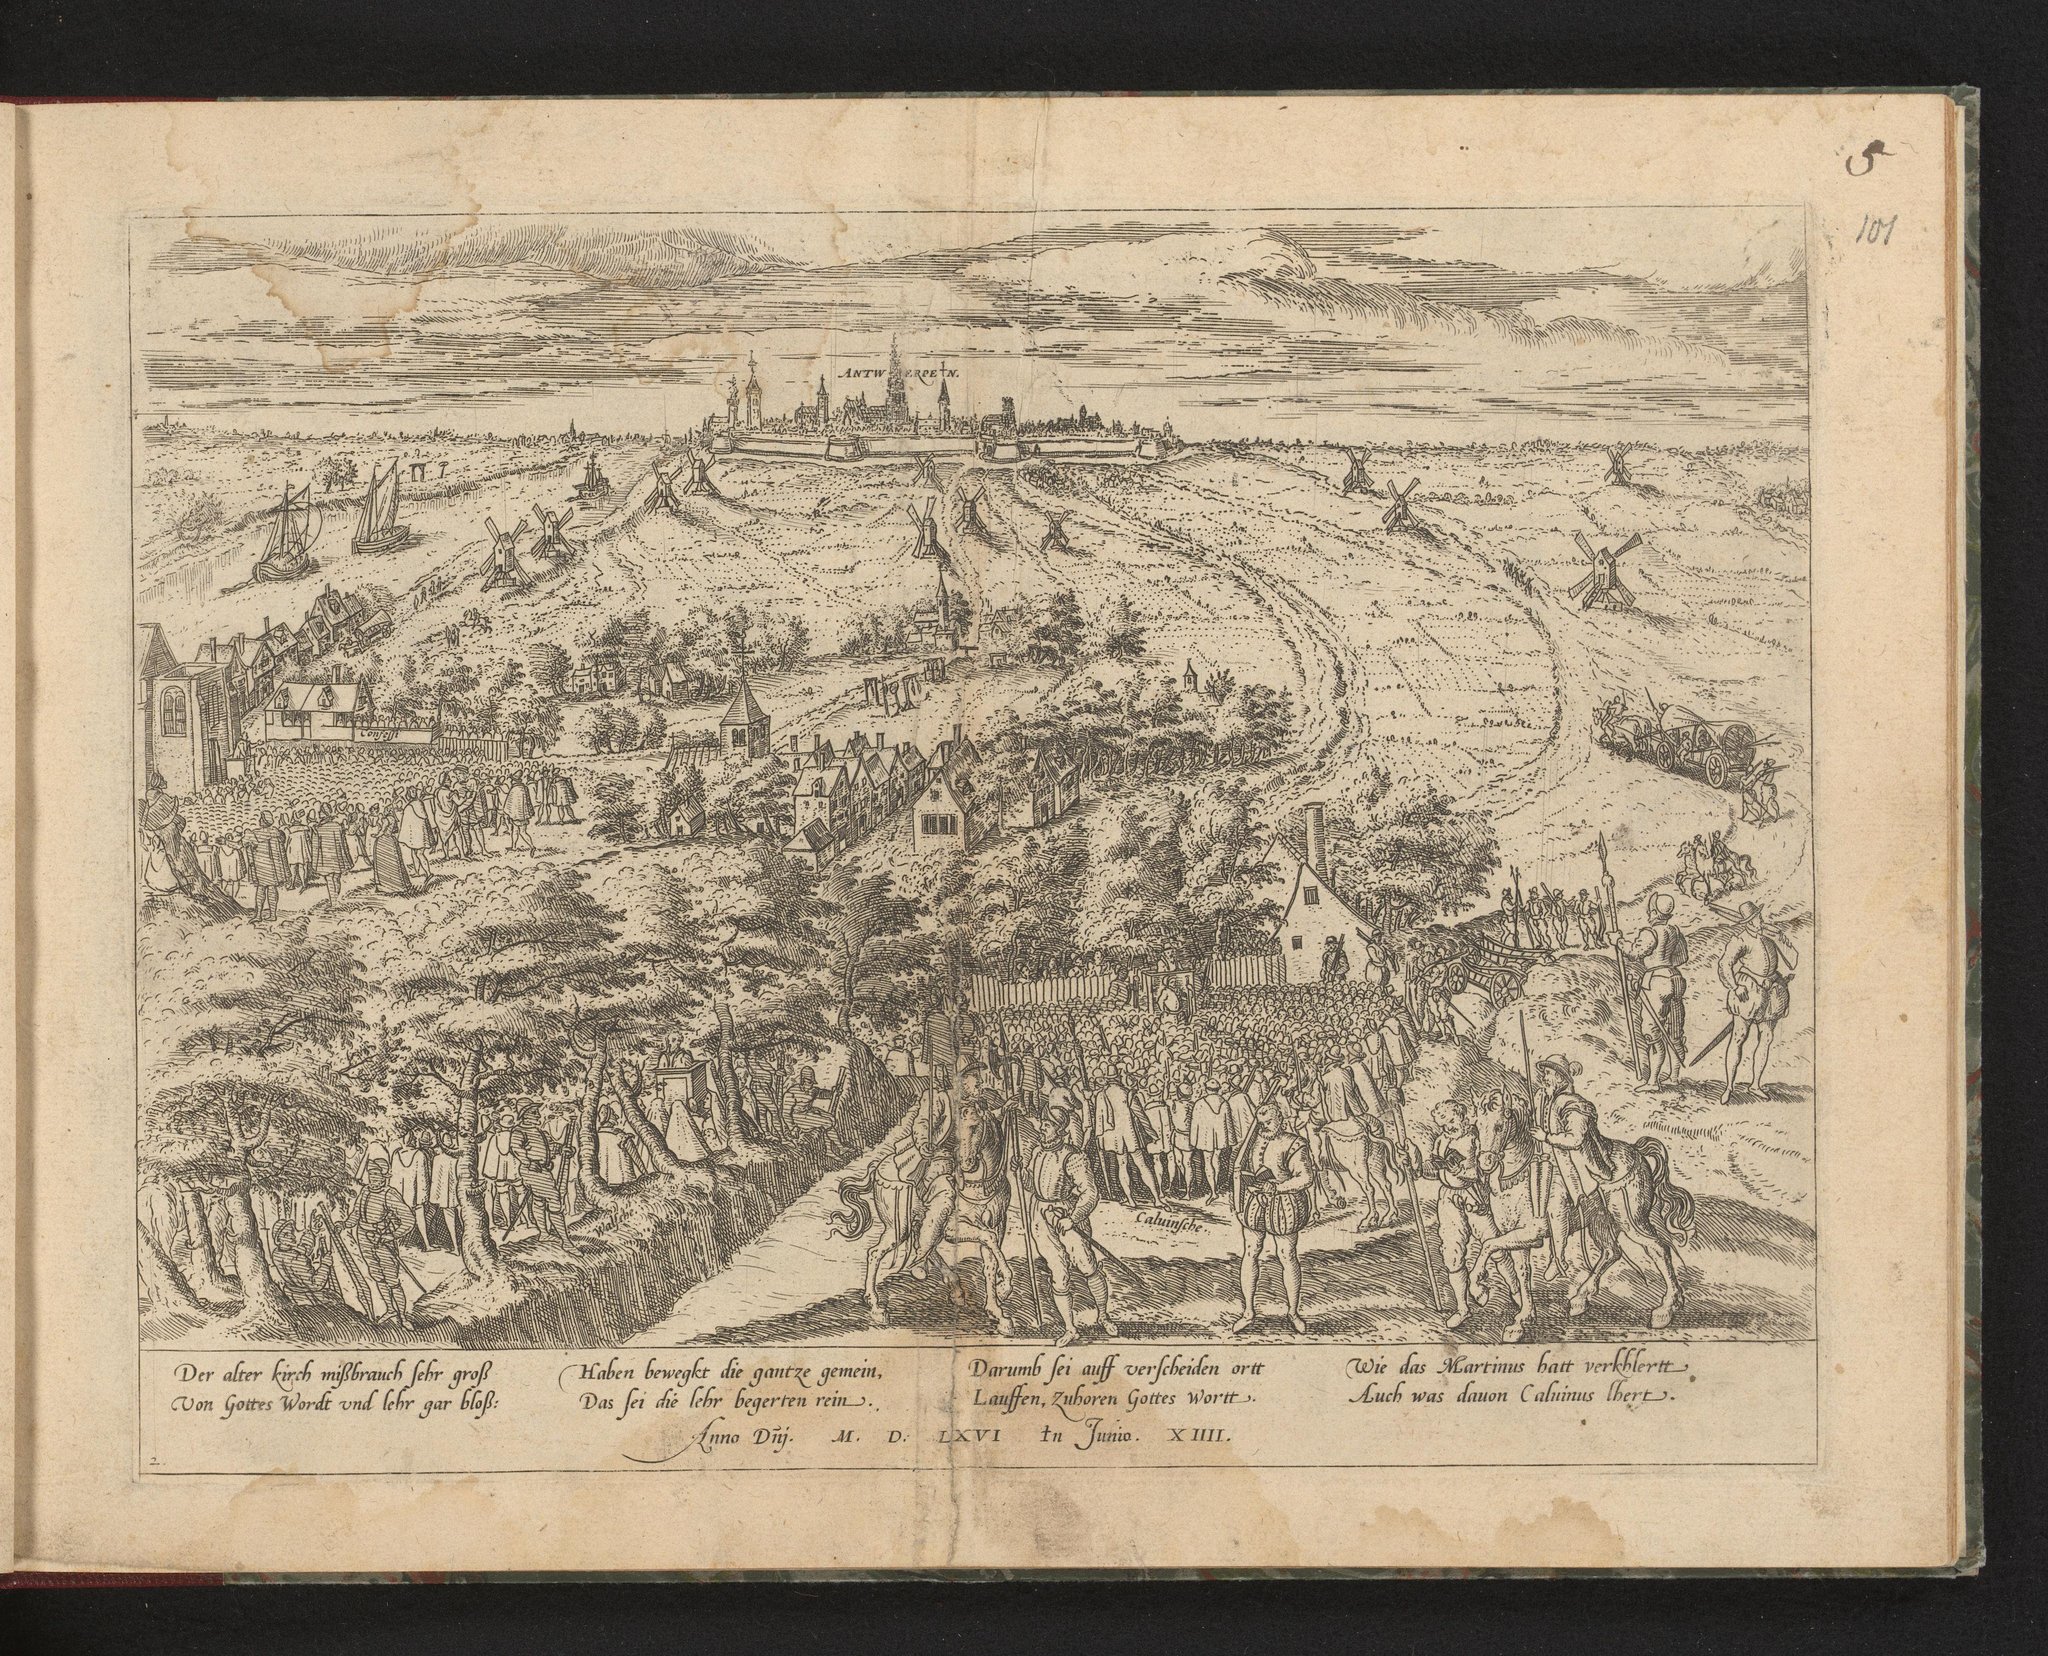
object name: print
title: Hagenpreken buiten Antwerpen, 1566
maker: frans hogenberg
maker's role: print maker, publisher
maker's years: 1538-1590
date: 1566-1570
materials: paper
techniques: etching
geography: cologne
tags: sermon ~ protestant service, antwerp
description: Hagenpreken buiten Antwerpen, 14 juni 1566. Calvinistische bijeenkomsten in de bossen, in de verte de stad Antwerpen. Op de voorgrond gewapende calvinistische ordebewakers. Met onderschrift van 8 regels in het Duits. Genummerd: 2. De prent maakt deel uit van een album. De prent maakt deel uit van een album.